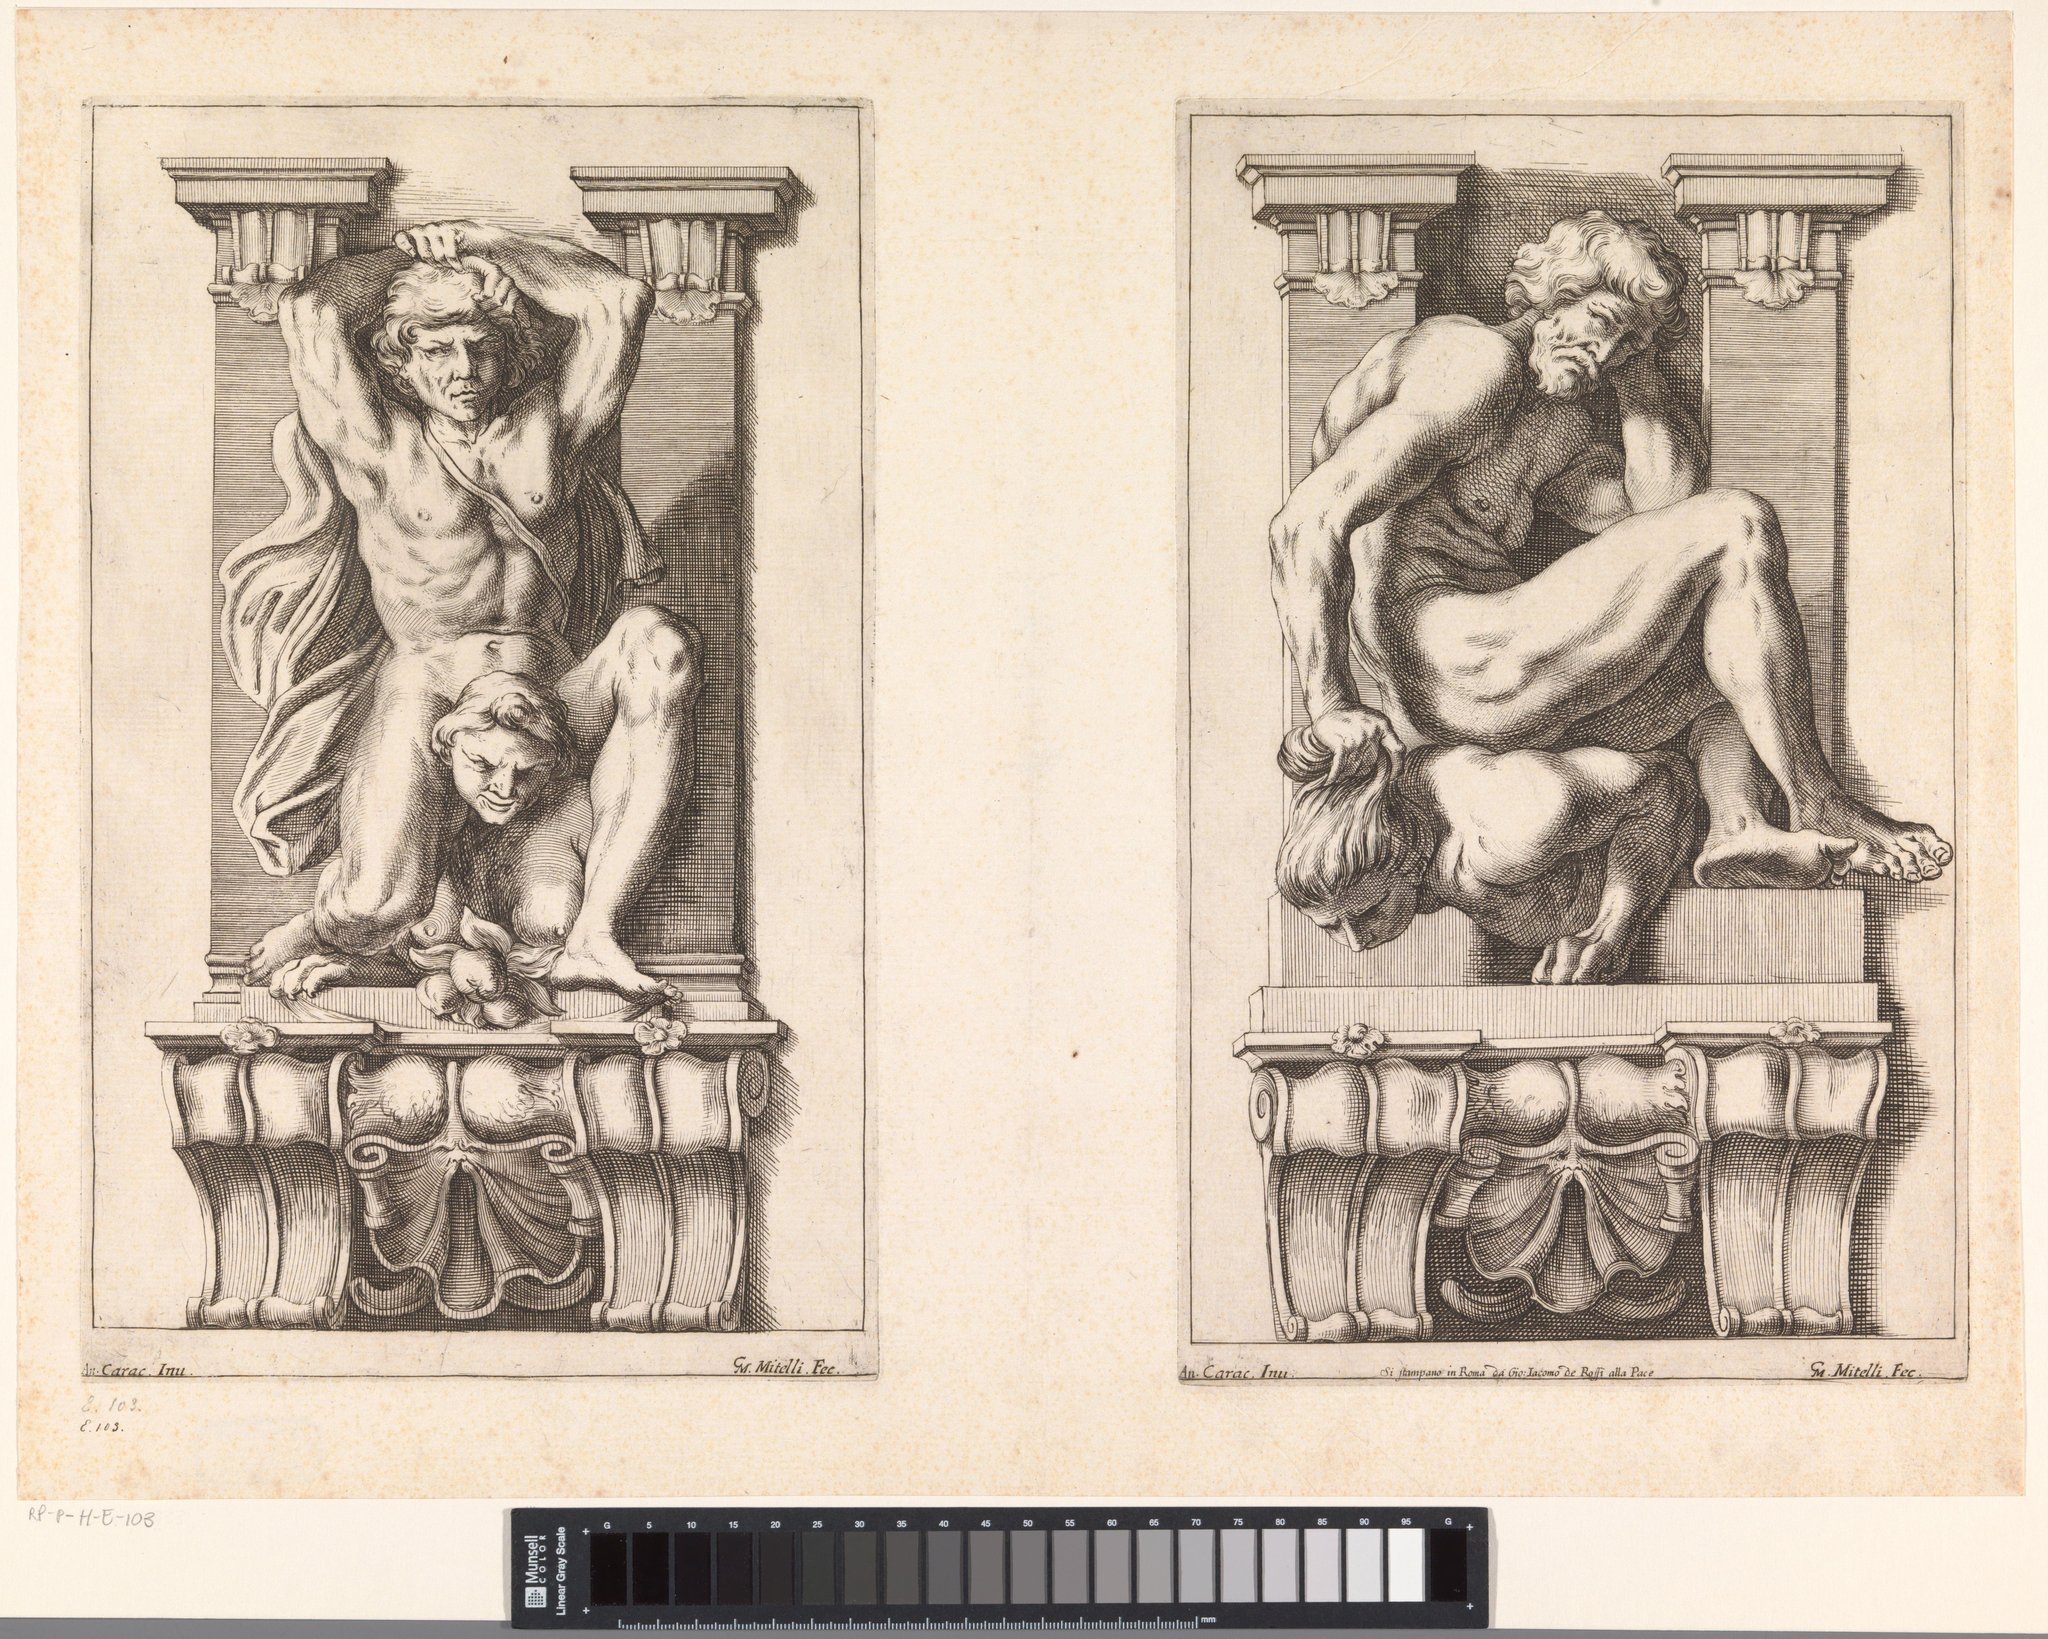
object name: print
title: Omzwervingen van Aeneas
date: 1663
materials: paper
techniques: etching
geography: italy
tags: the (nude) human figure; 'corpo humano' (ripa), other architectural details (console), harpies (classical mythology)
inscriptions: collector's mark: ‘Hinloopen’, collector's mark: Lugt 11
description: Deze prent maakt deel uit van een reeks van 20 prenten (+ titelprent) naar de fresco's door de Carracci's in Palazzo Fava Ghisilieri te Bologna. Deze prent maakte oorspronkelijk deel uit van liber nr. 22 van de Atlas van Rome, uit de collectie Hinloopen. In dit album waren een aantal prentreeksen naar bekende zeventiende eeuwse frescoseries bijeengebonden. In 1709 heeft Schijnvoet op last van de burgemeesters van Amsterdam de collectie herordend. De prenten uit liber 22 kwamen terrecht in Schijnvoet boek nr. 10. De laatst gedateerde reeks in het album is gedateerd 1691. Het album moet dus na deze datum gebonden zijn. De band is in de Rijksakademietijd uit elkaar gehaald. De marges van de prenten zijn bij het opbergen in het Rijksprentenkabinet vaak drastisch afgesneden. Van een aantal series waren de prenten teruggeslagen om in het album te passen. (Zie: Waals, Jan van der. De prentschat van Michiel Hinloopen. 's-Gravenhage: SDU uitgeverij, 1988, pp. 173-174.)